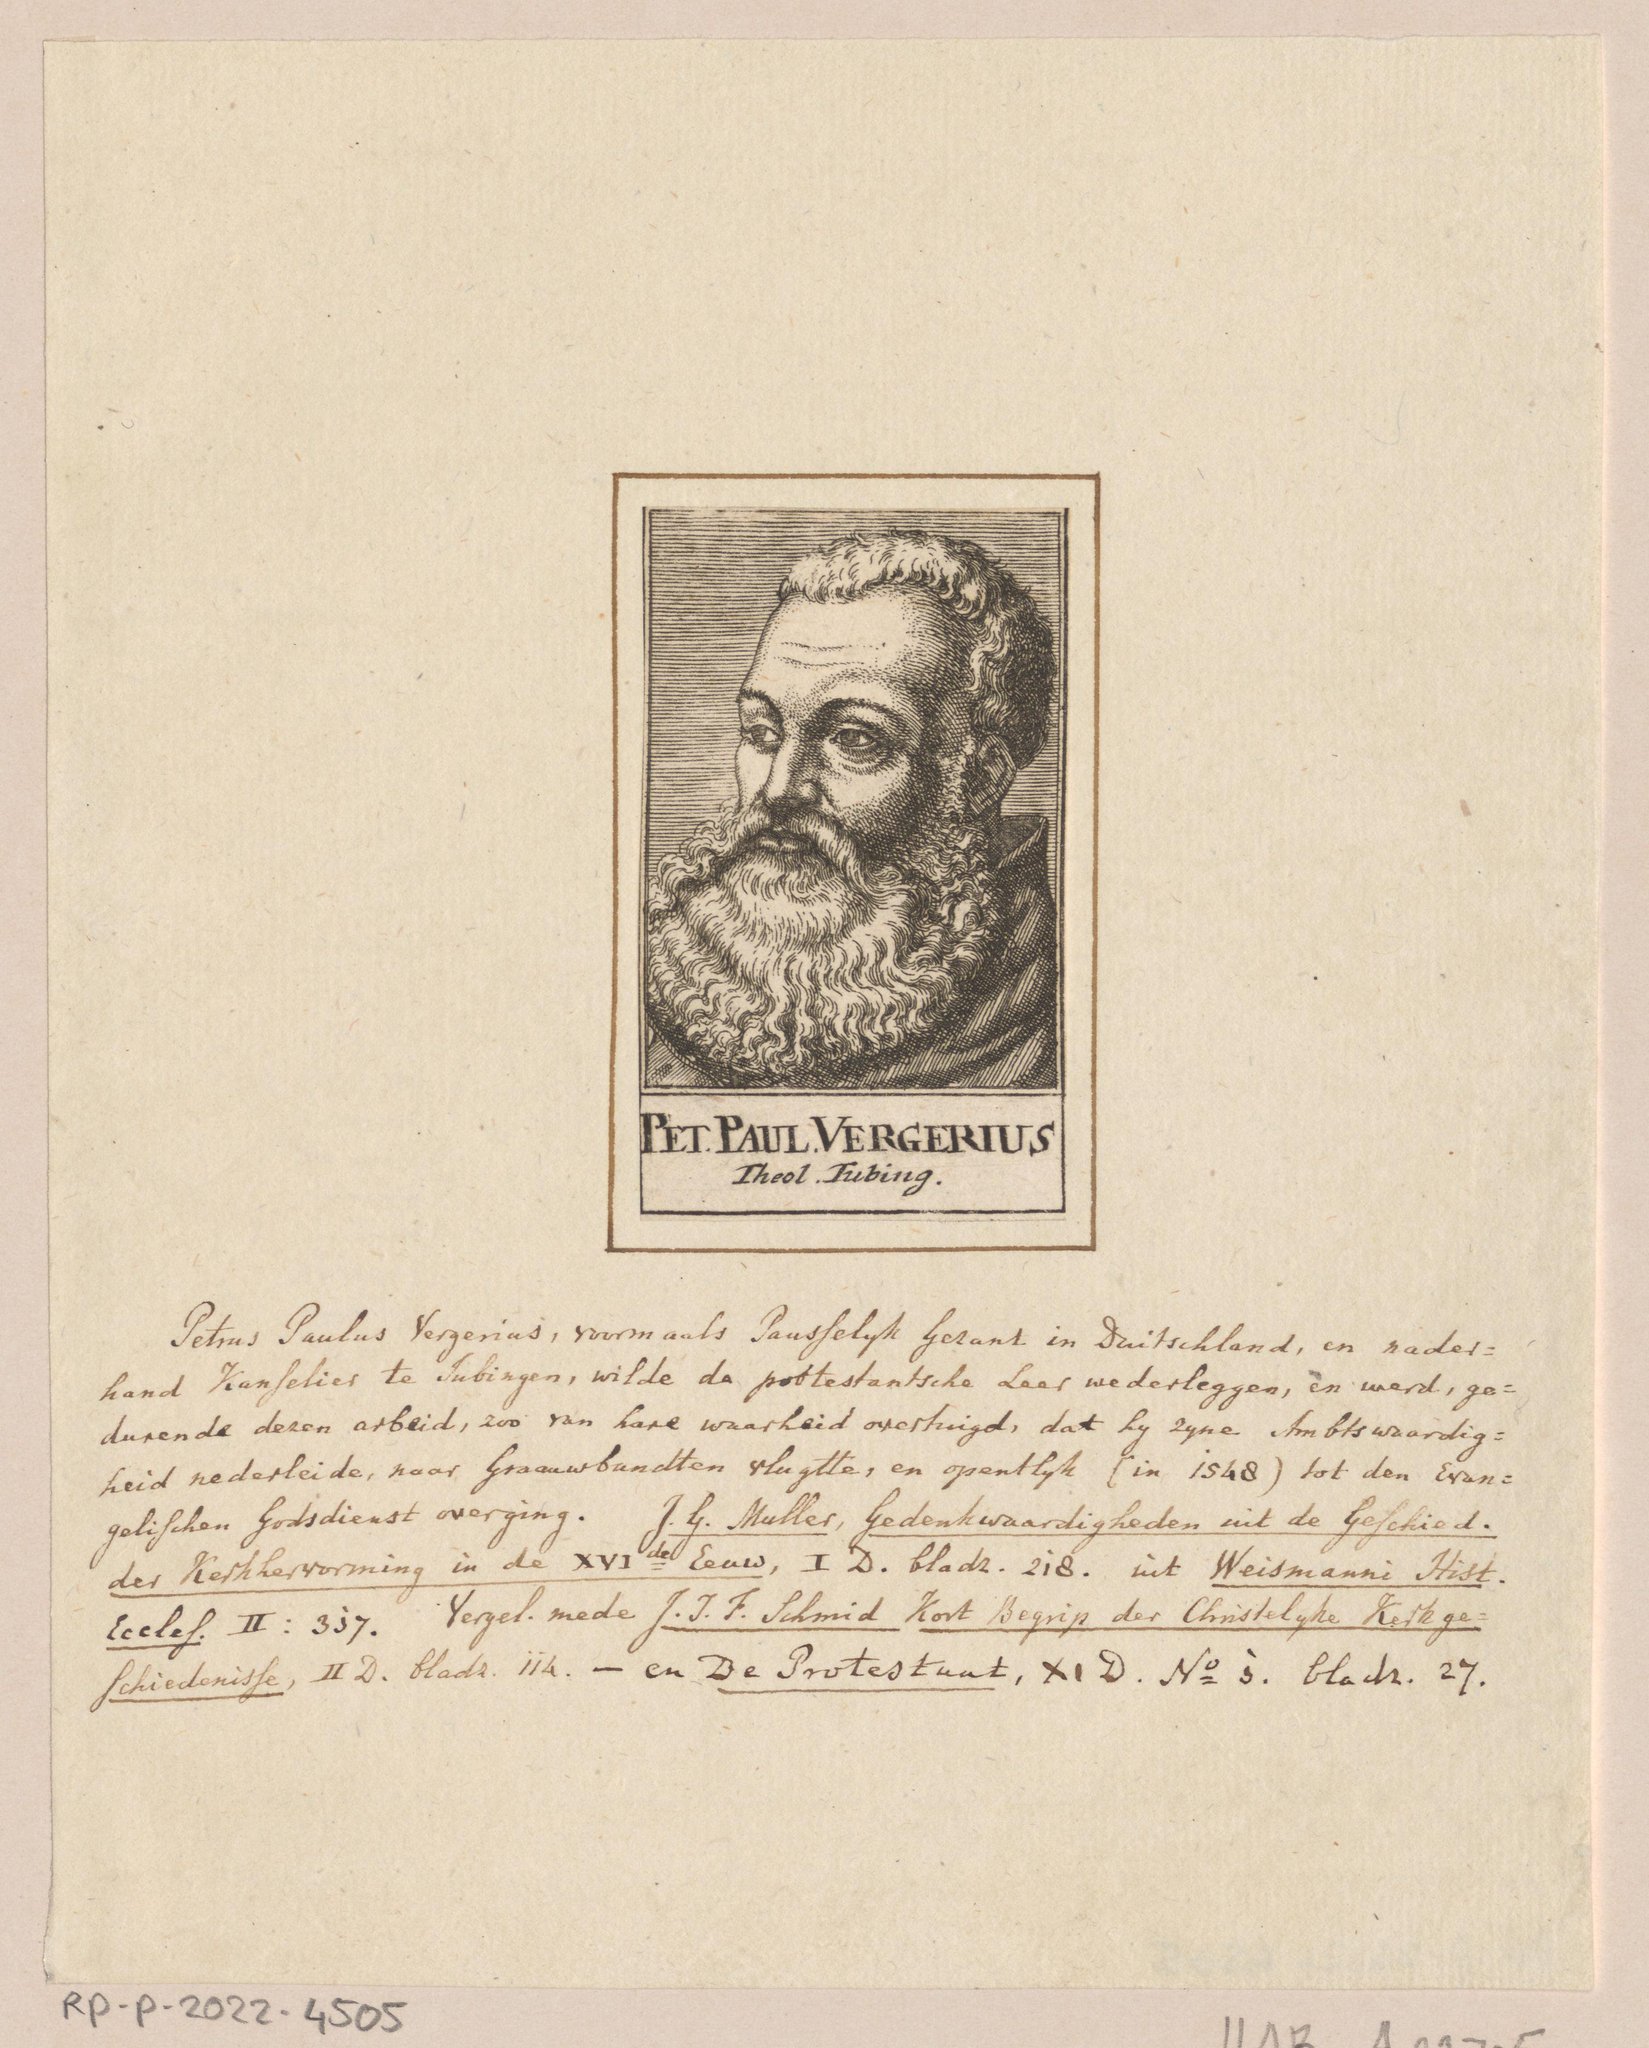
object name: print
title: Portret van Pietro Paulo Vergerio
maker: Anonymous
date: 1688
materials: paper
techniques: etching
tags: archbishop, bishop, etc. (roman catholic), historical persons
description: Prent waarschijnlijk uit: Freher, Paul. Theatrum Virorum Eruditione Clarorum Tomus Posterior. Neurenberg: Johann Hofmann, 1688.